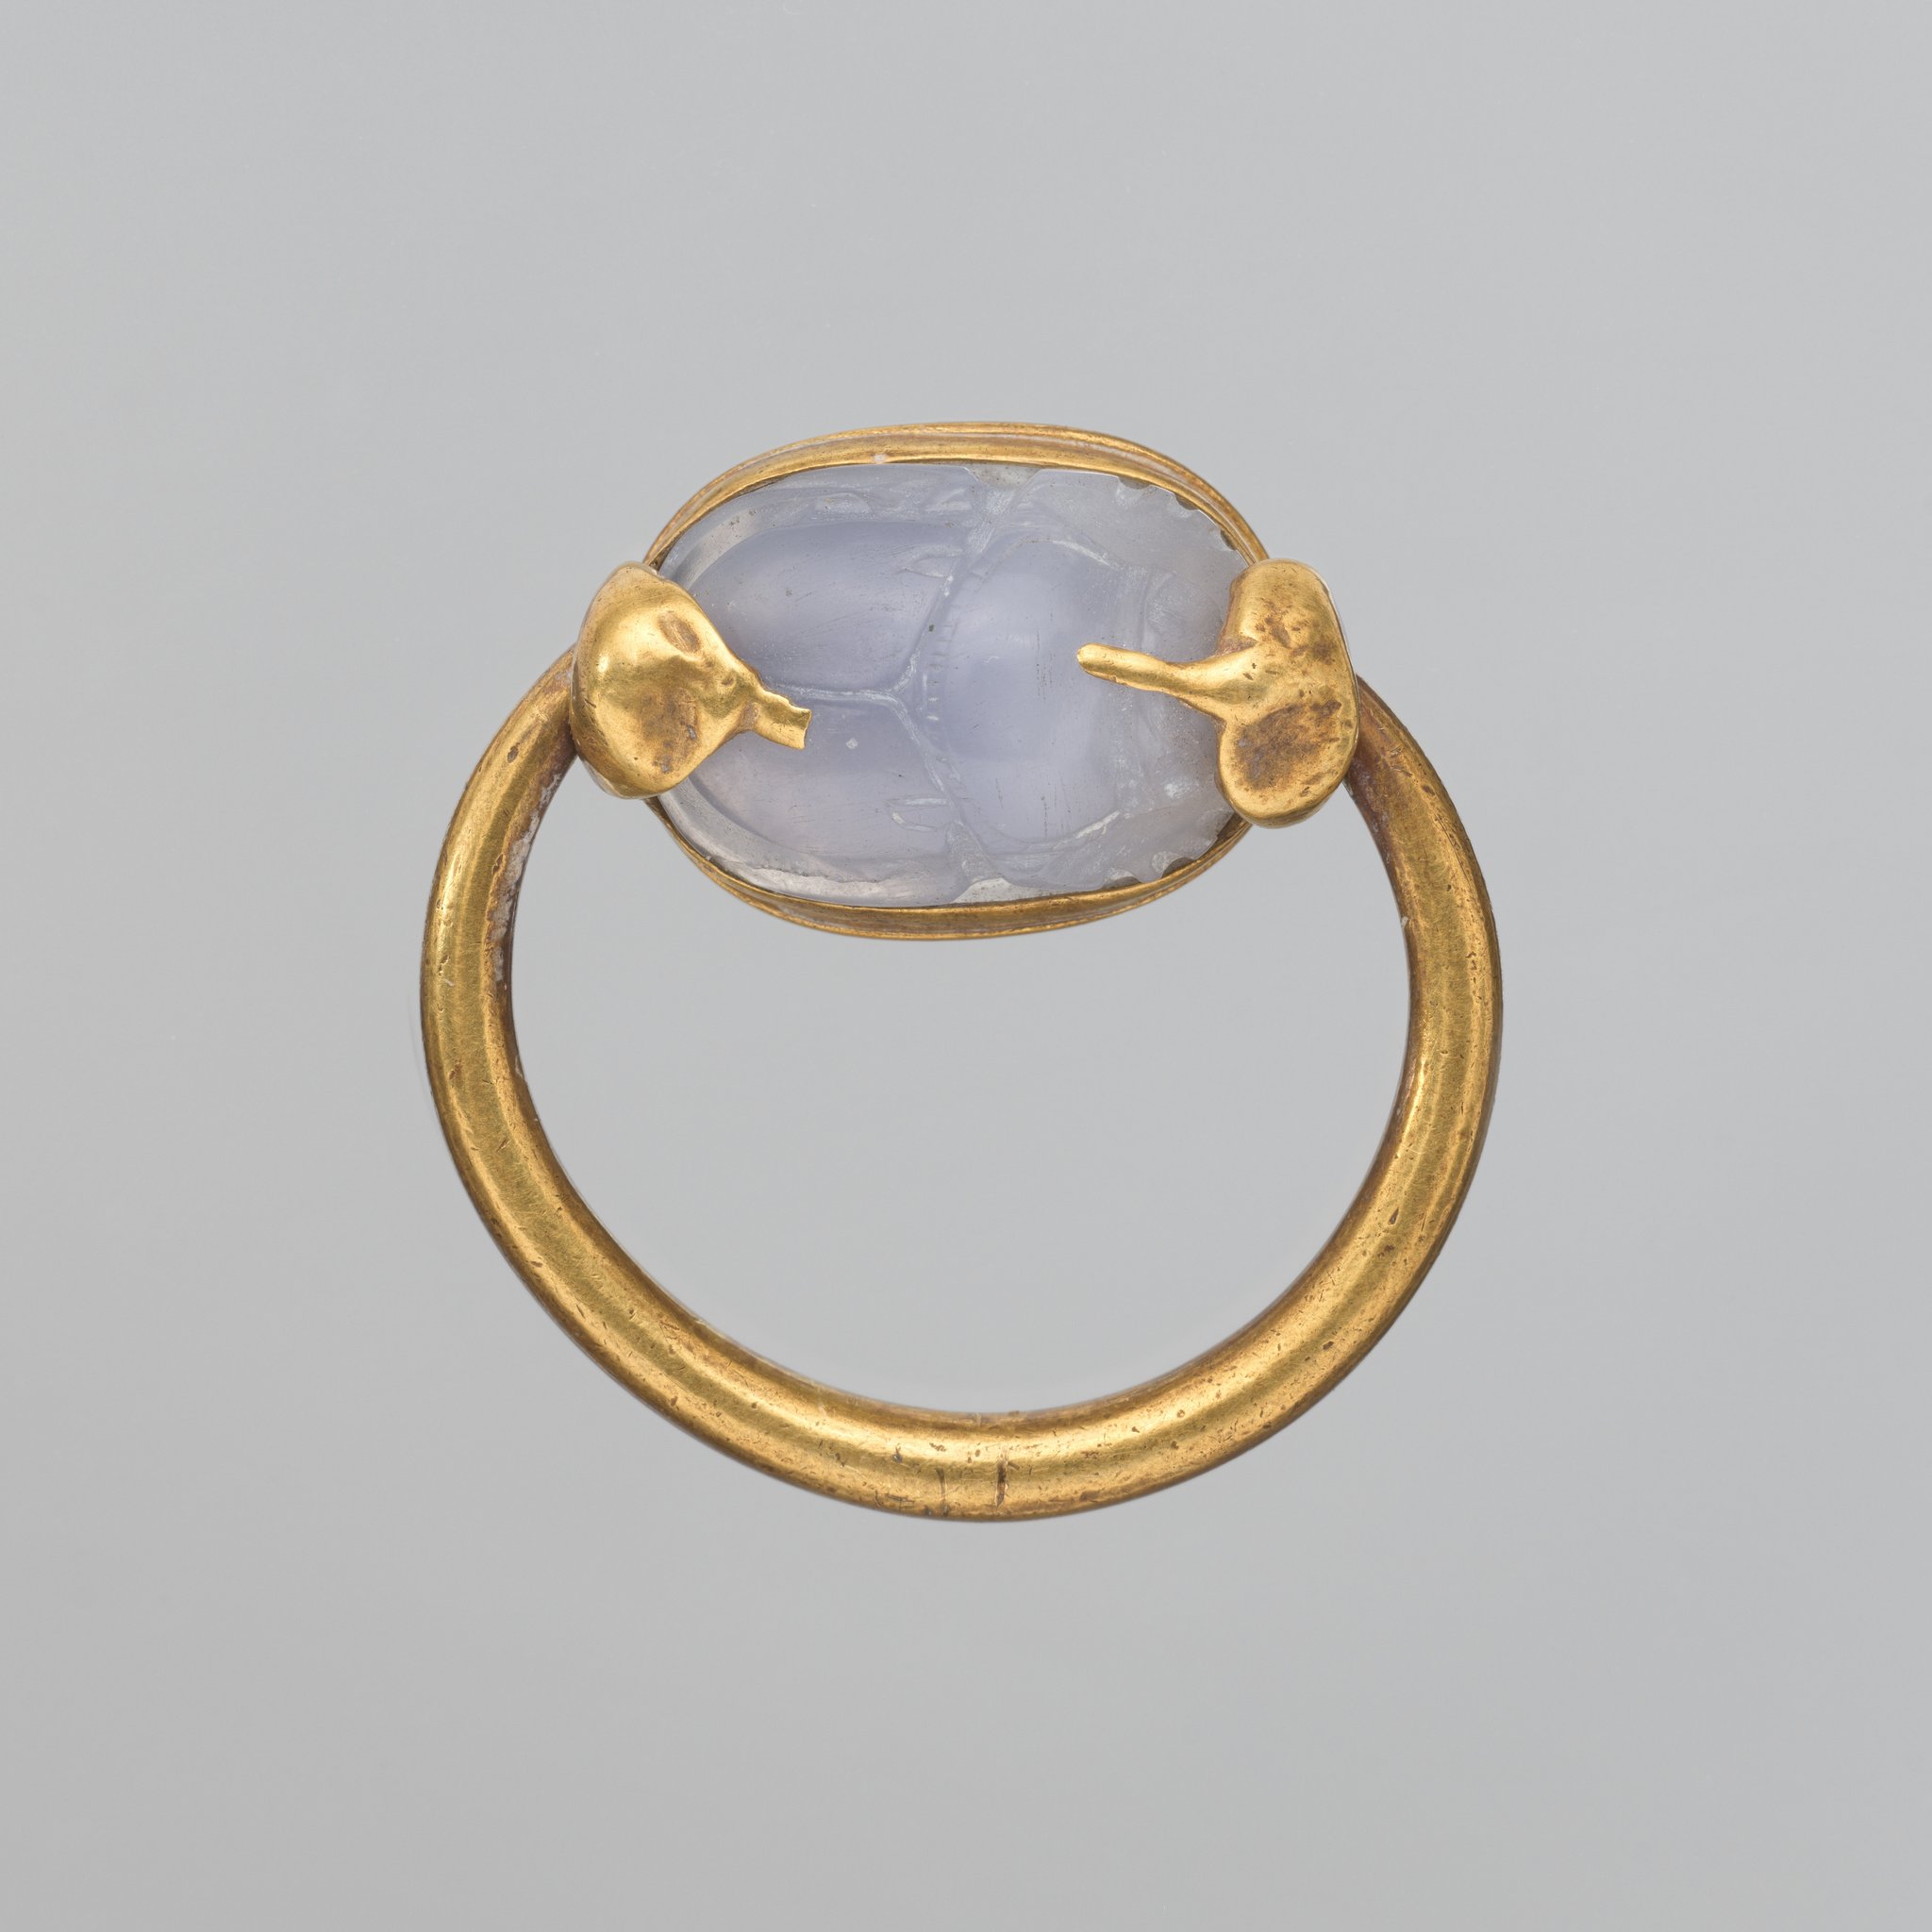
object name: ring with scaraboid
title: Gold ring with chalcedony scaraboid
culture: cypriot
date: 500-401 BCE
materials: stone, gold